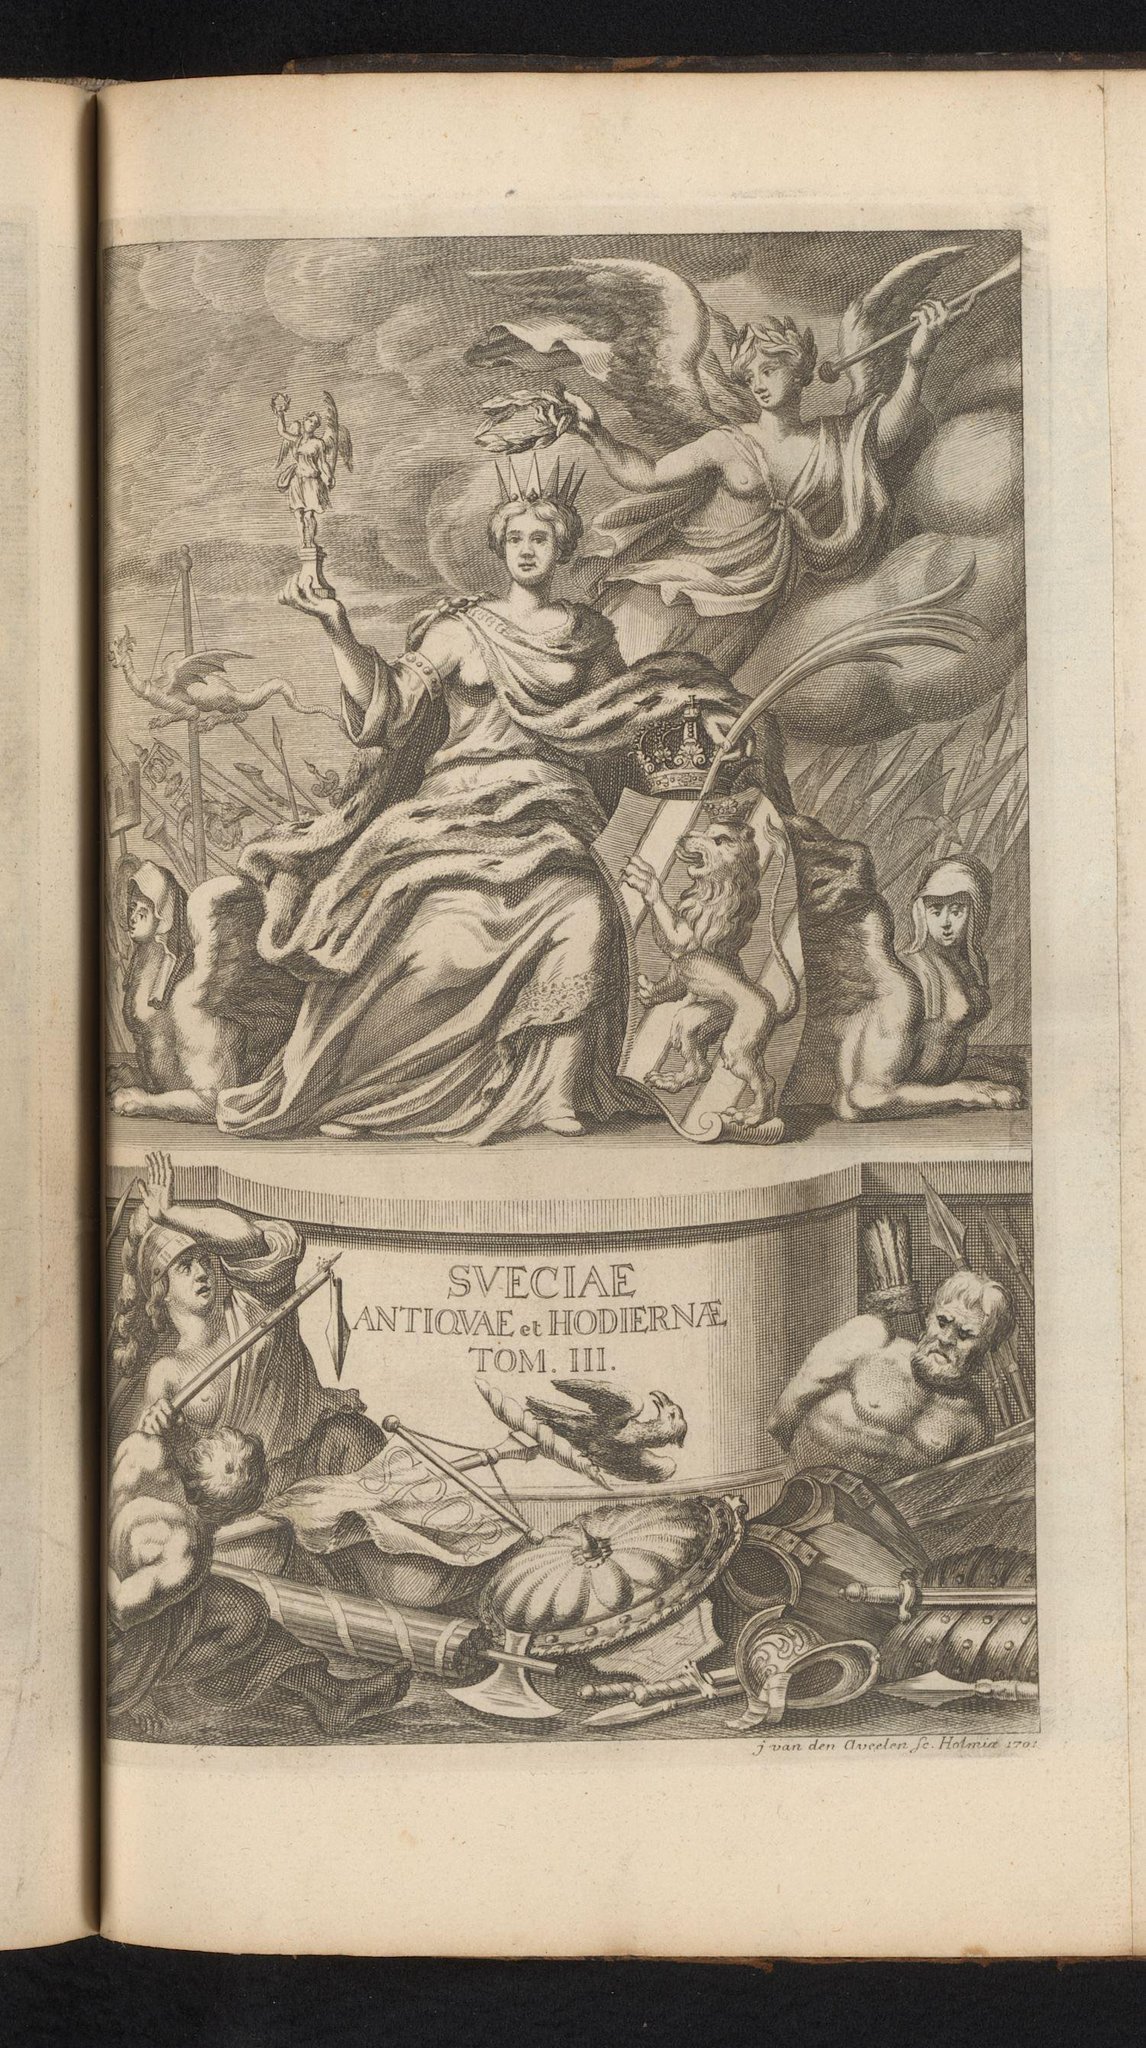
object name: album leaf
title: Titelprent met de personificatie van Götaland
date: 1701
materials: paper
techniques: engraving, etching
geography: stockholm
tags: personifications of countries, nations, states, districts, etc., fame; 'fama', 'fama buona', 'fama chiara' (ripa)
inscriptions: date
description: Allegorische titelprent voor de reeks getiteld: Suecia antiqua et hodierna. Op een sokkel de vrouwelijke personificatie van Götaland, het zuidelijkste landsdeel van Zweden. In haar handen een palmtak en Victoria. Faam houdt een lauwerkrans boven haar hoofd. Op de voorgrond wapens en verslagen vijanden. De prent maakt deel uit van een album.